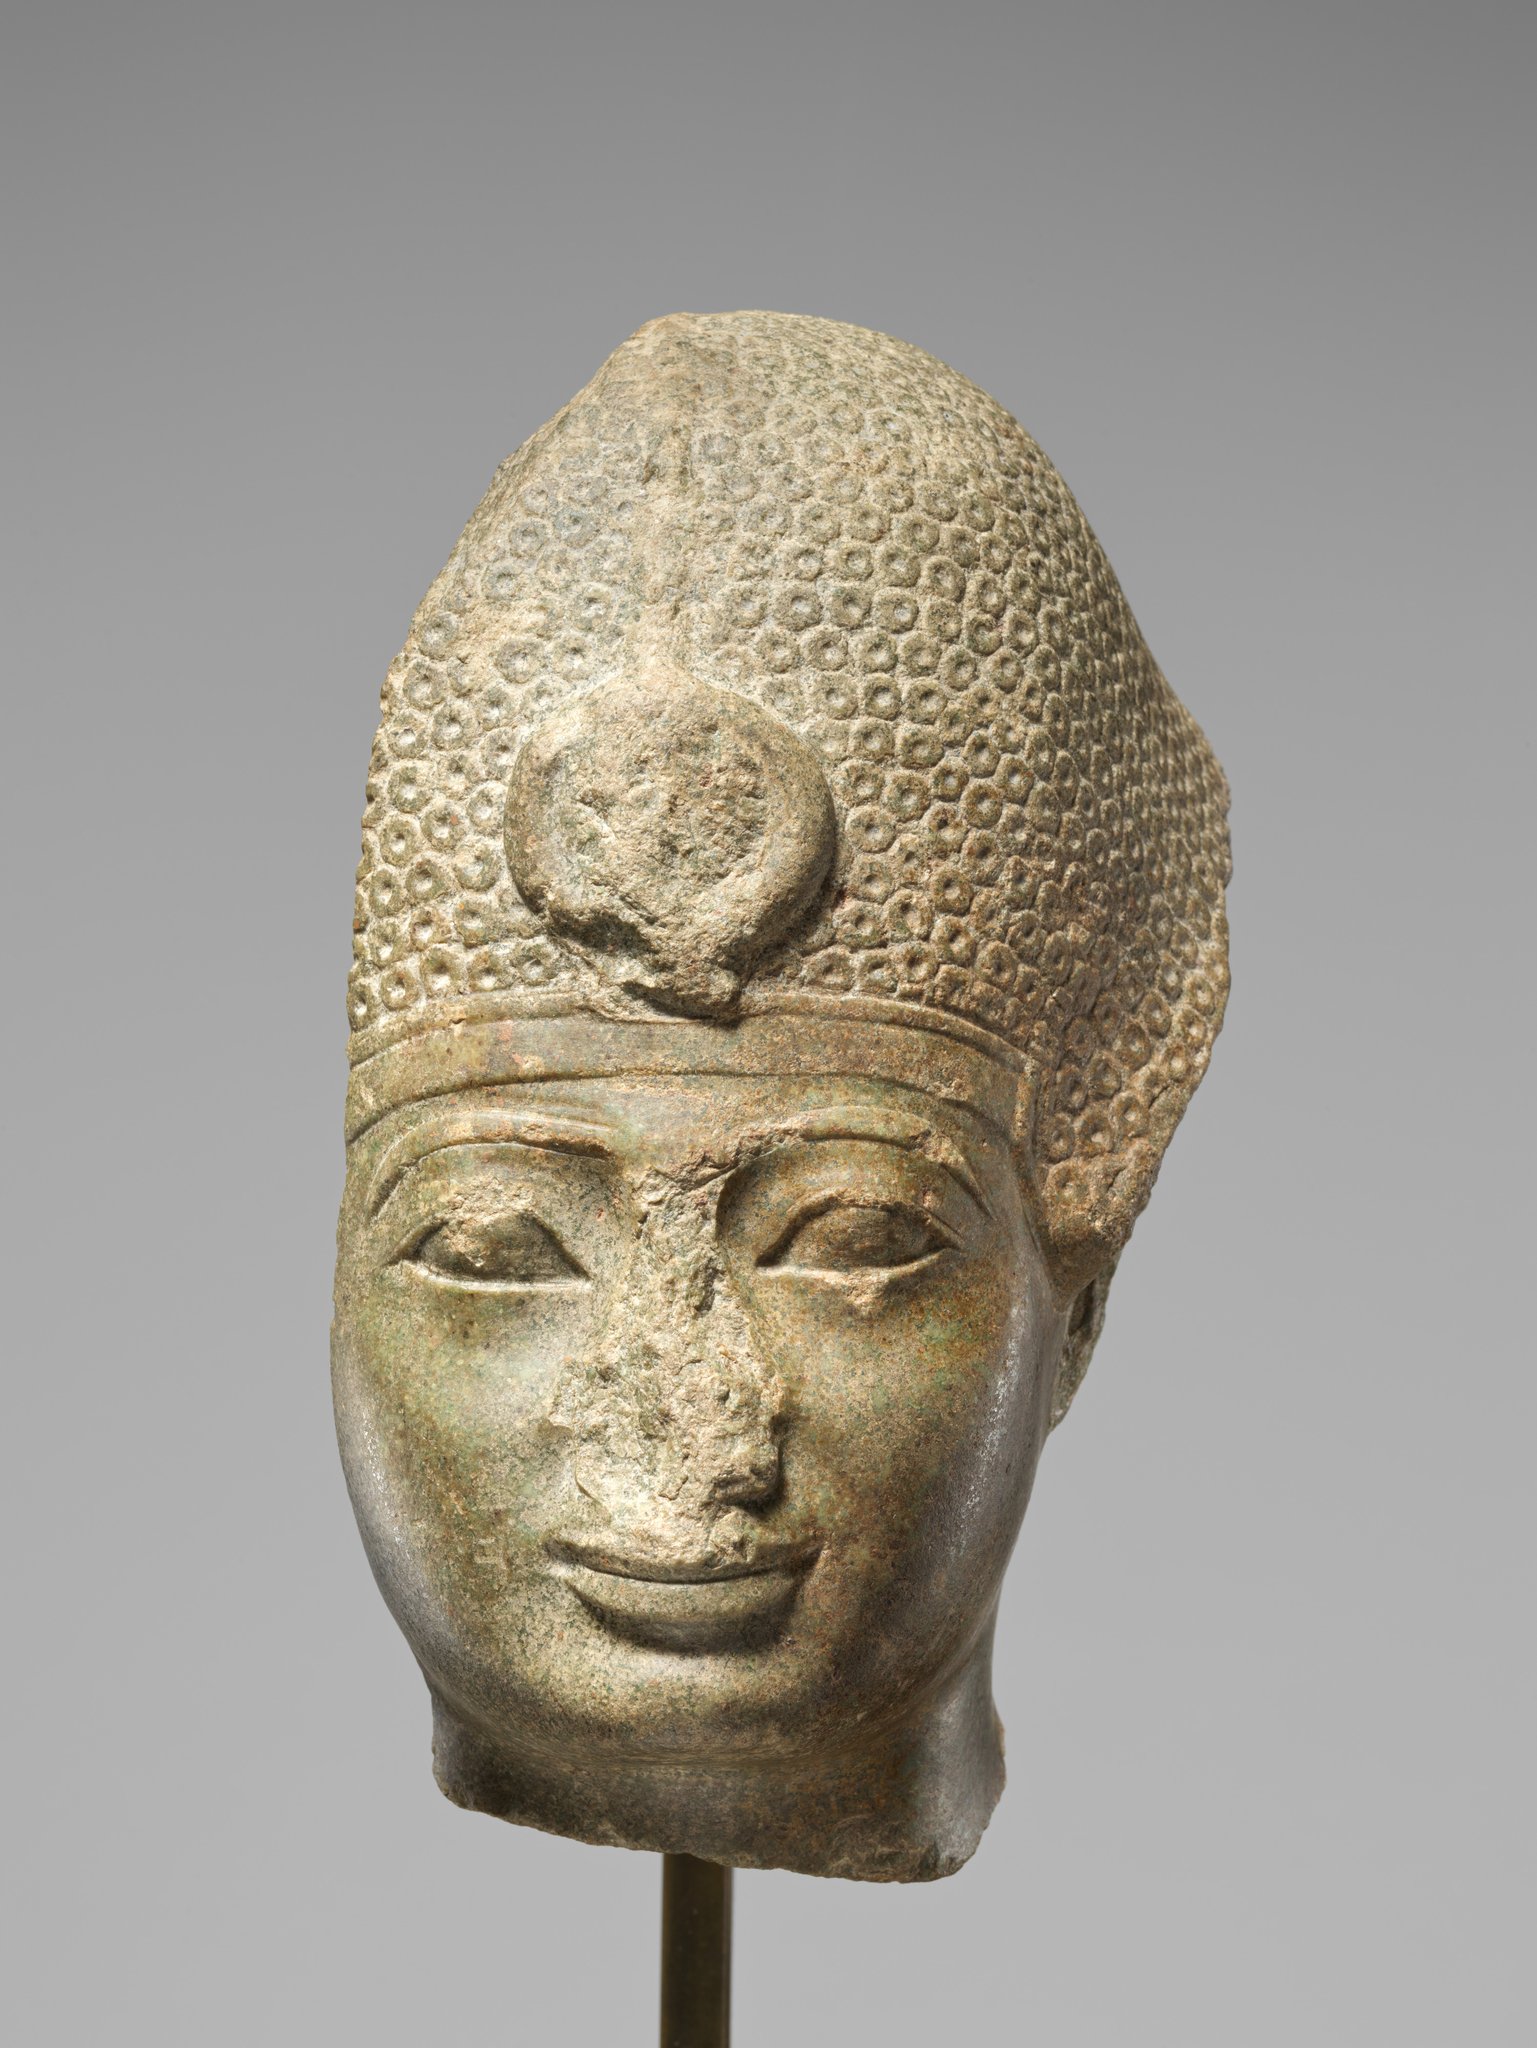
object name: head, king, thutose iv, amenhotep iii, blue crown, khepresh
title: Head of a Thutmose IV or a Young Amenhotep III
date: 1400-1380 BCE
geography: egypt